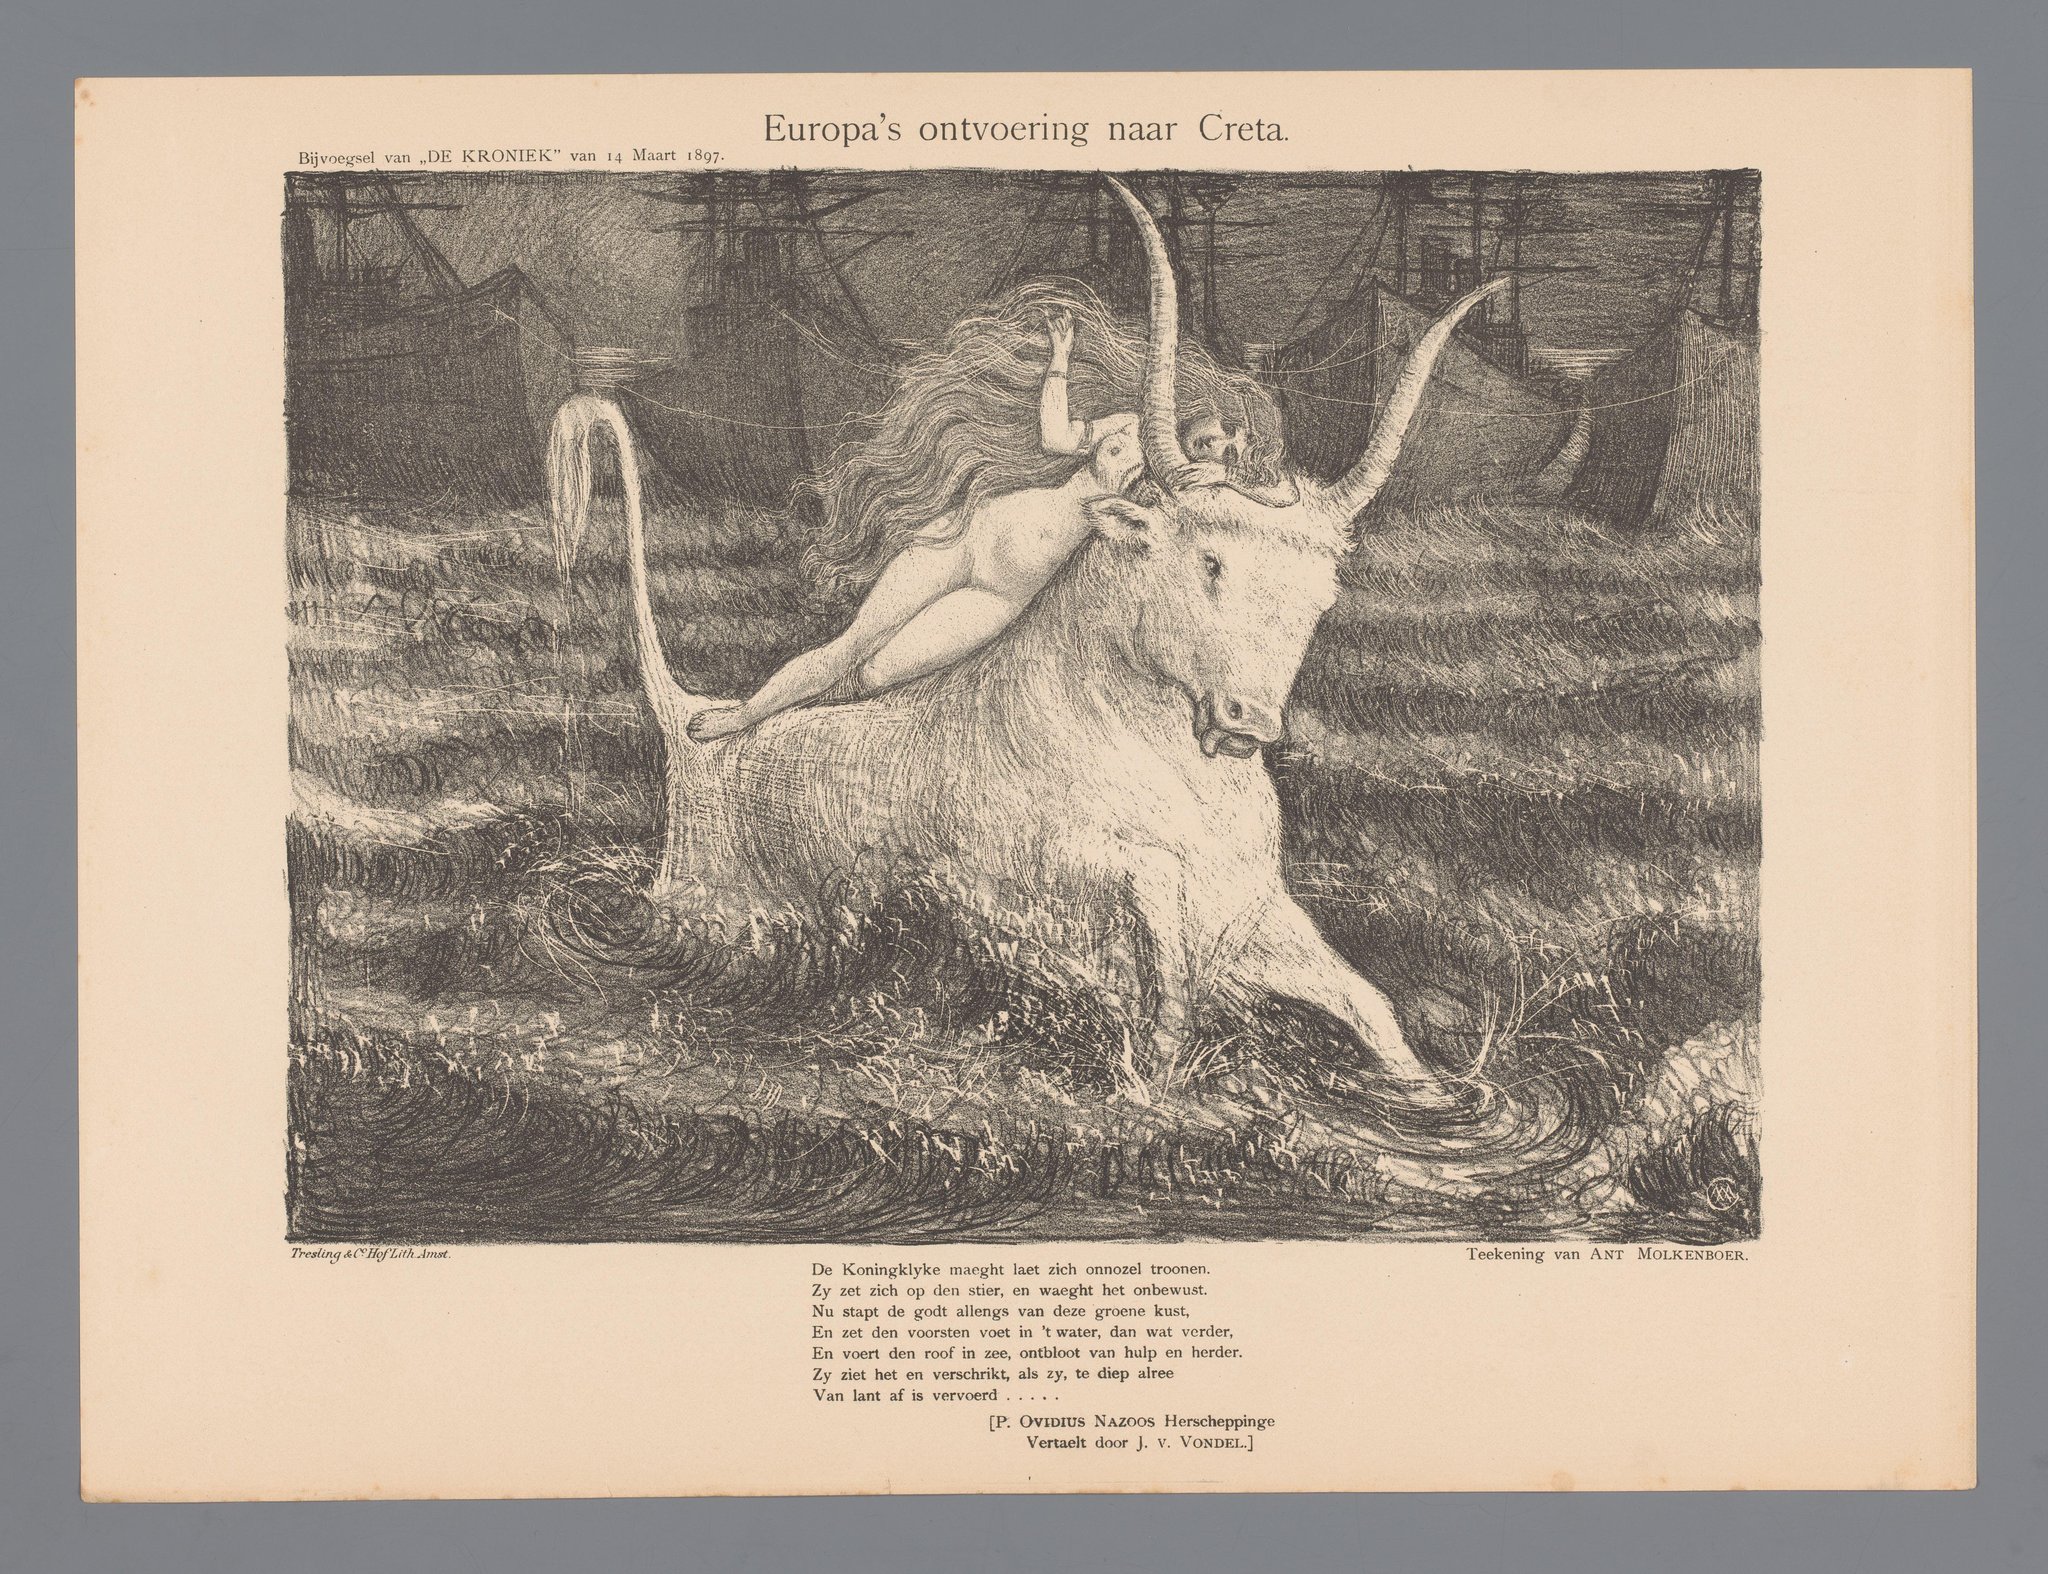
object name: print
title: Europa's ontvoering naar Creta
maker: anton molkenboer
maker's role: print maker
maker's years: 1872-1960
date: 1897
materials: paper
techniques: lithograph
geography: amsterdam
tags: jupiter, usually in the shape of a white bull, abducts europa and carries her across the water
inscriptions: date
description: Prent uit het bijvoegsel van: De Kroniek 3 (1897), 14 maart 1897.